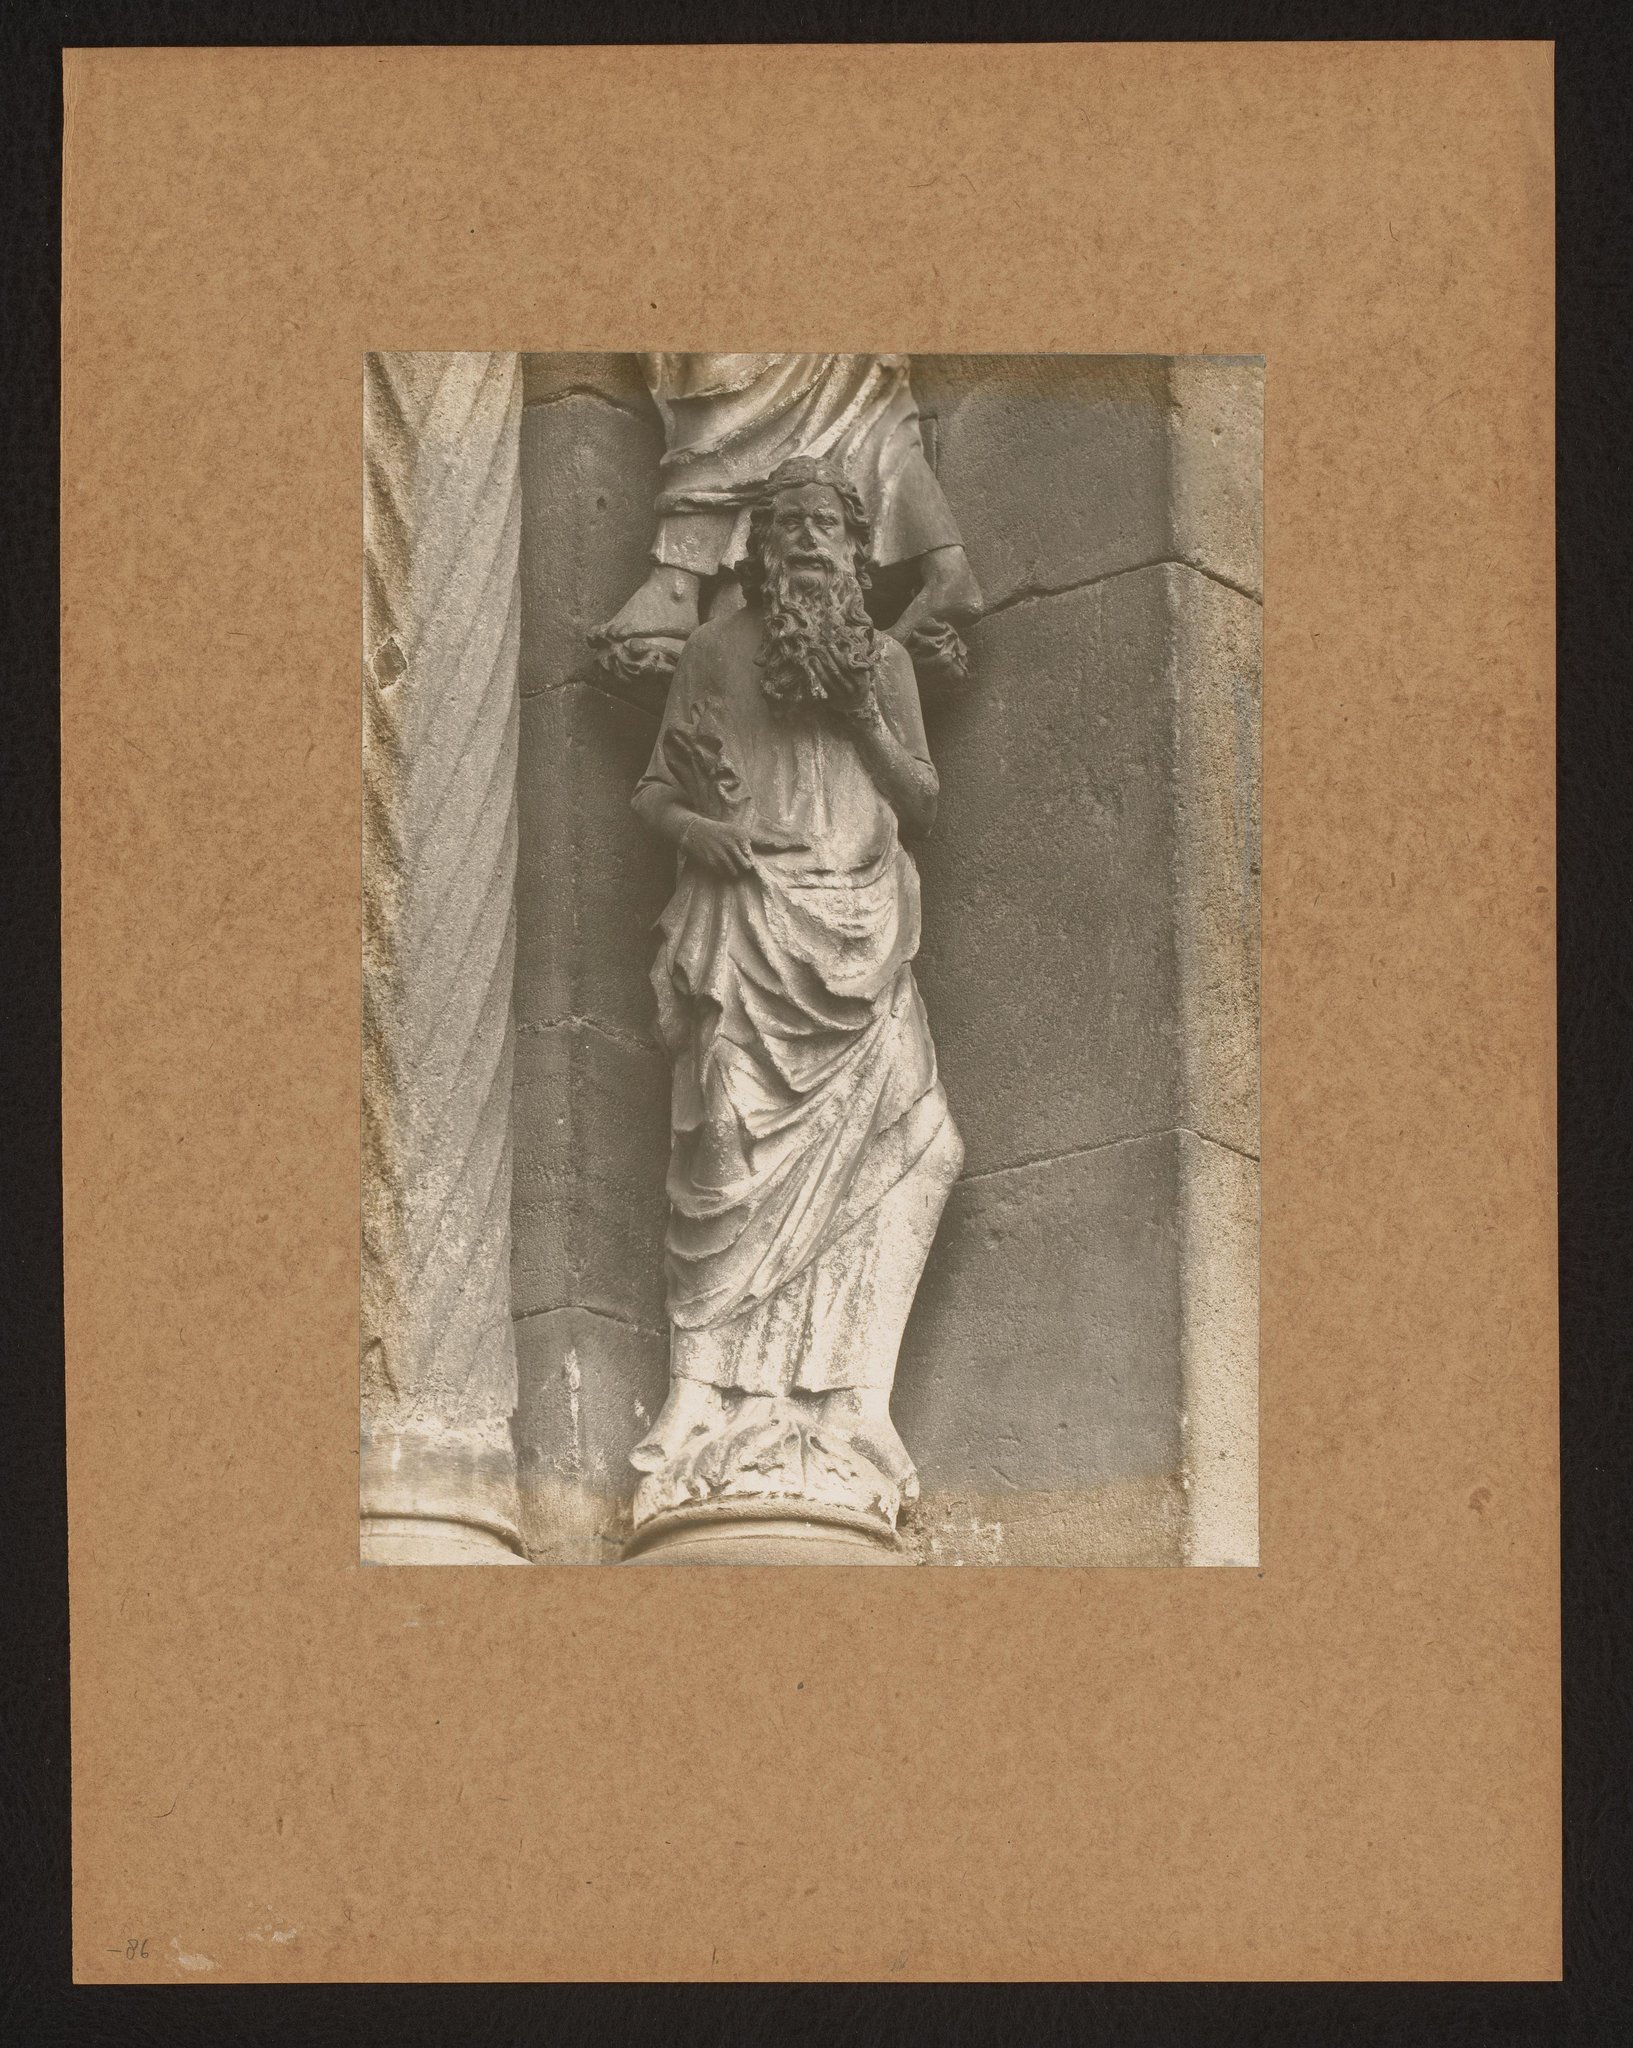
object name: photograph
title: Fürstentor P.r.6.v.NO.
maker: Anonymous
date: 1900-1920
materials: paper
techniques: gelatin silver print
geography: bamberg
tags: church (exterior)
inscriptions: number: ‘88’